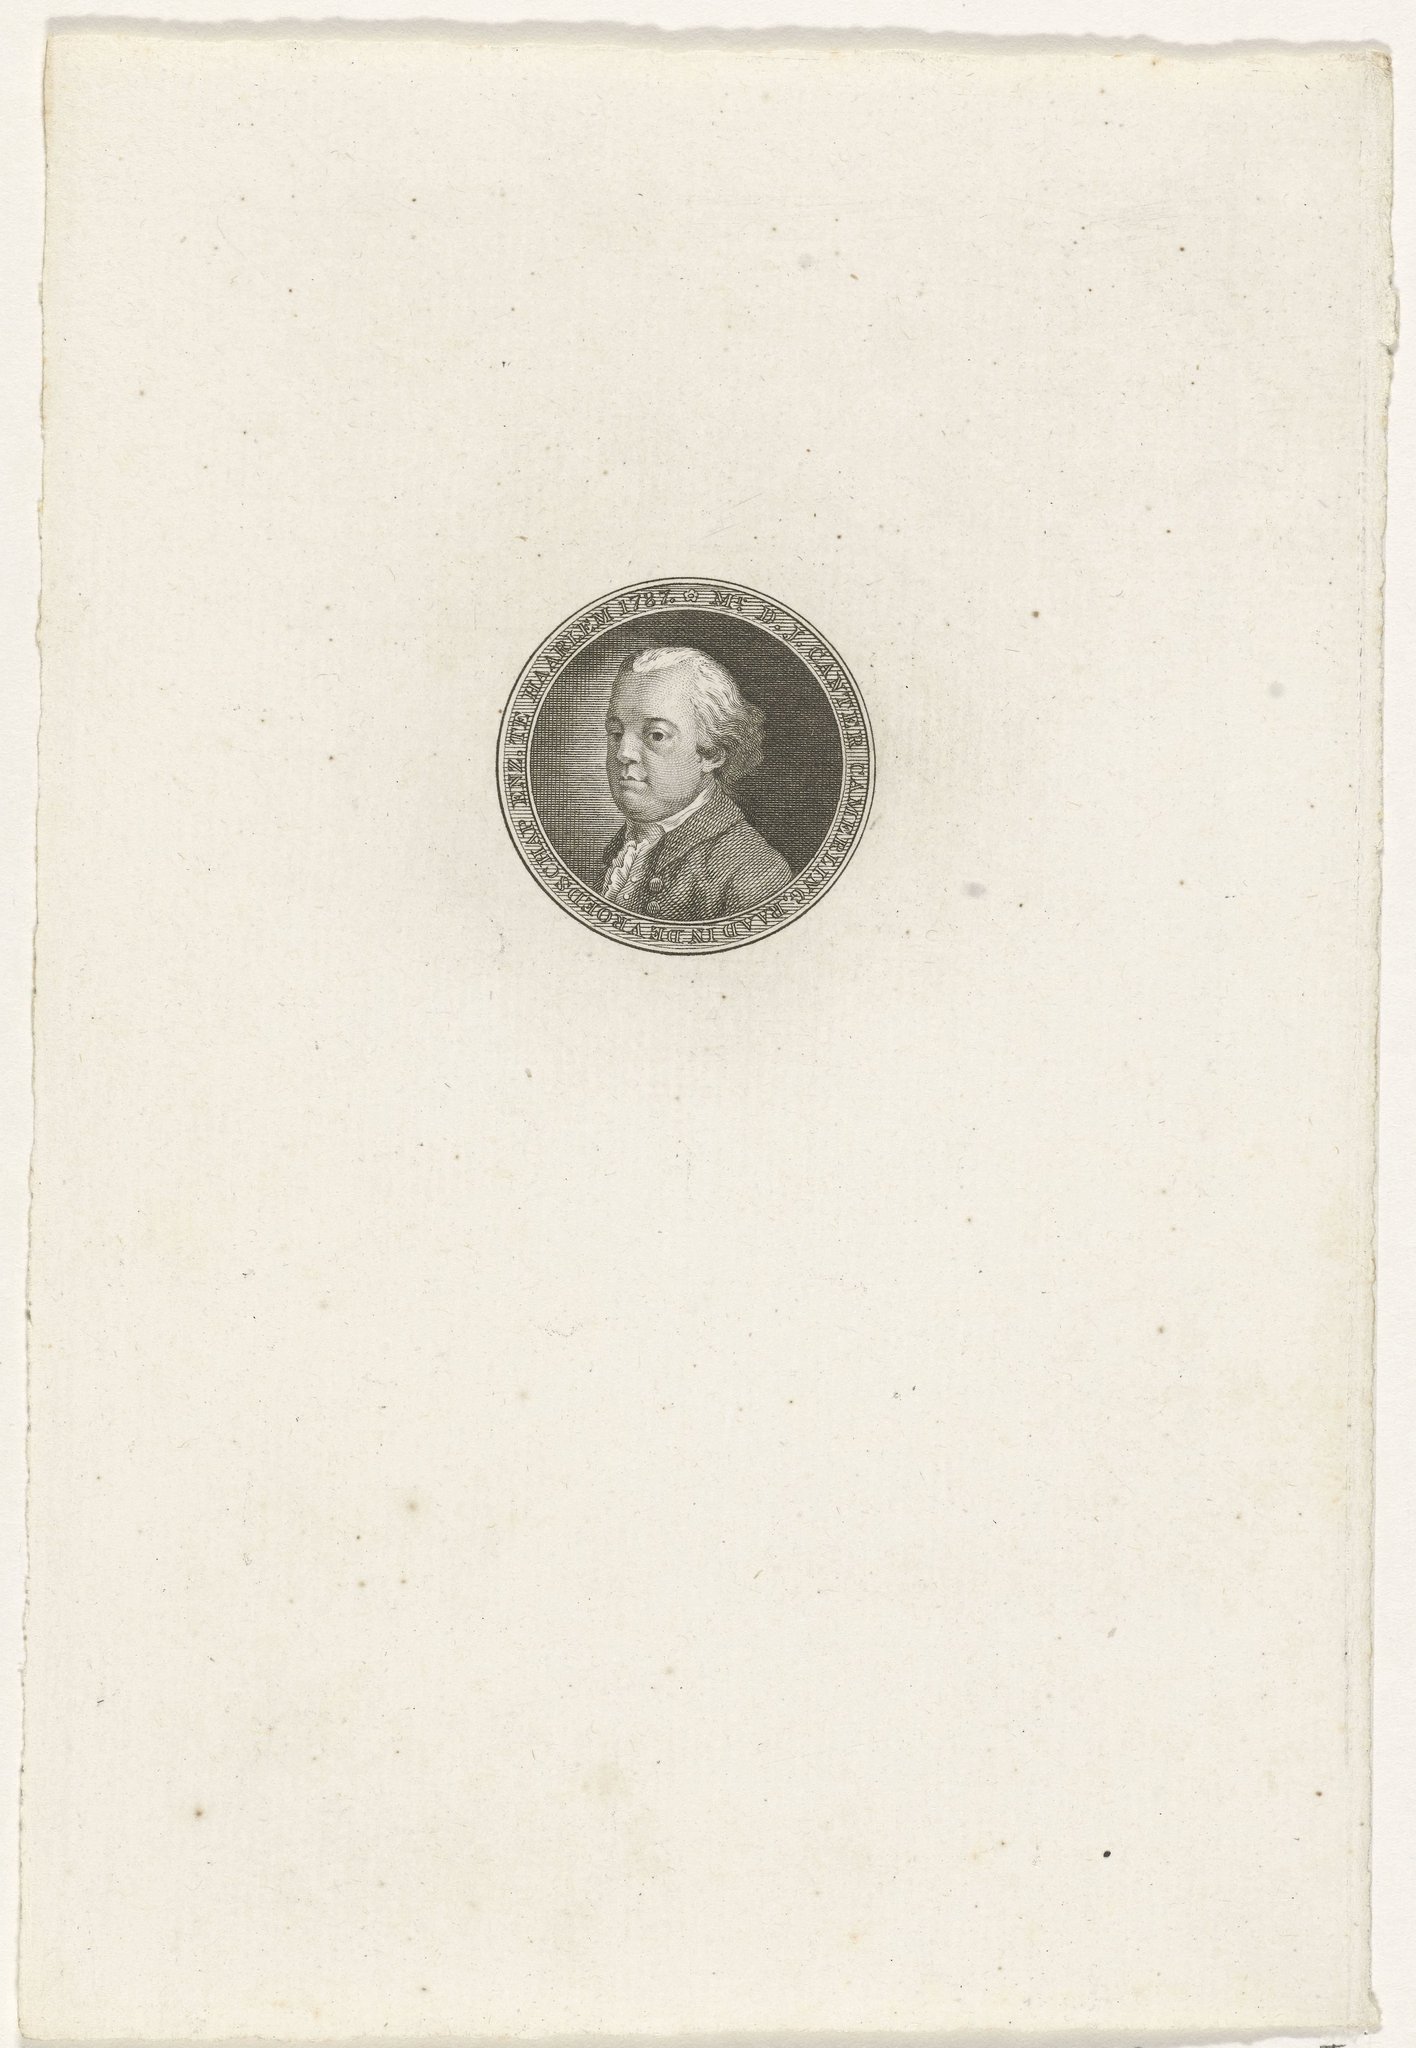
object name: print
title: Portret van Daniël Jacobus Canter Camerling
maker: abraham jacobsz. hulk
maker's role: print maker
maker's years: 1751-1817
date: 1787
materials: paper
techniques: engraving, etching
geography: paris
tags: mayor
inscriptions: collector's mark: Lugt 2228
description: Buste van Daniël Jacobus Canter Camerling naar links in medaillon met randschrift in het Nederlands.